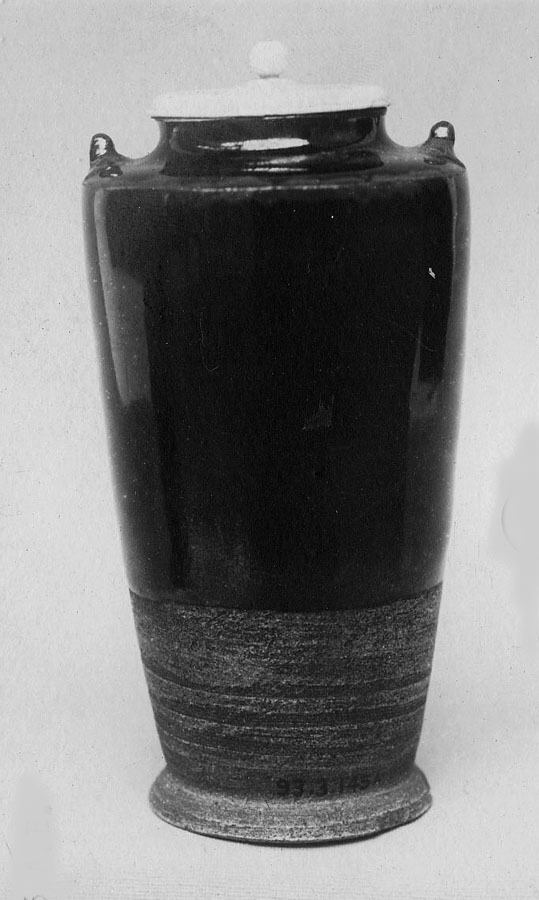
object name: tea jar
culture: japanese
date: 1650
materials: clay, glaze